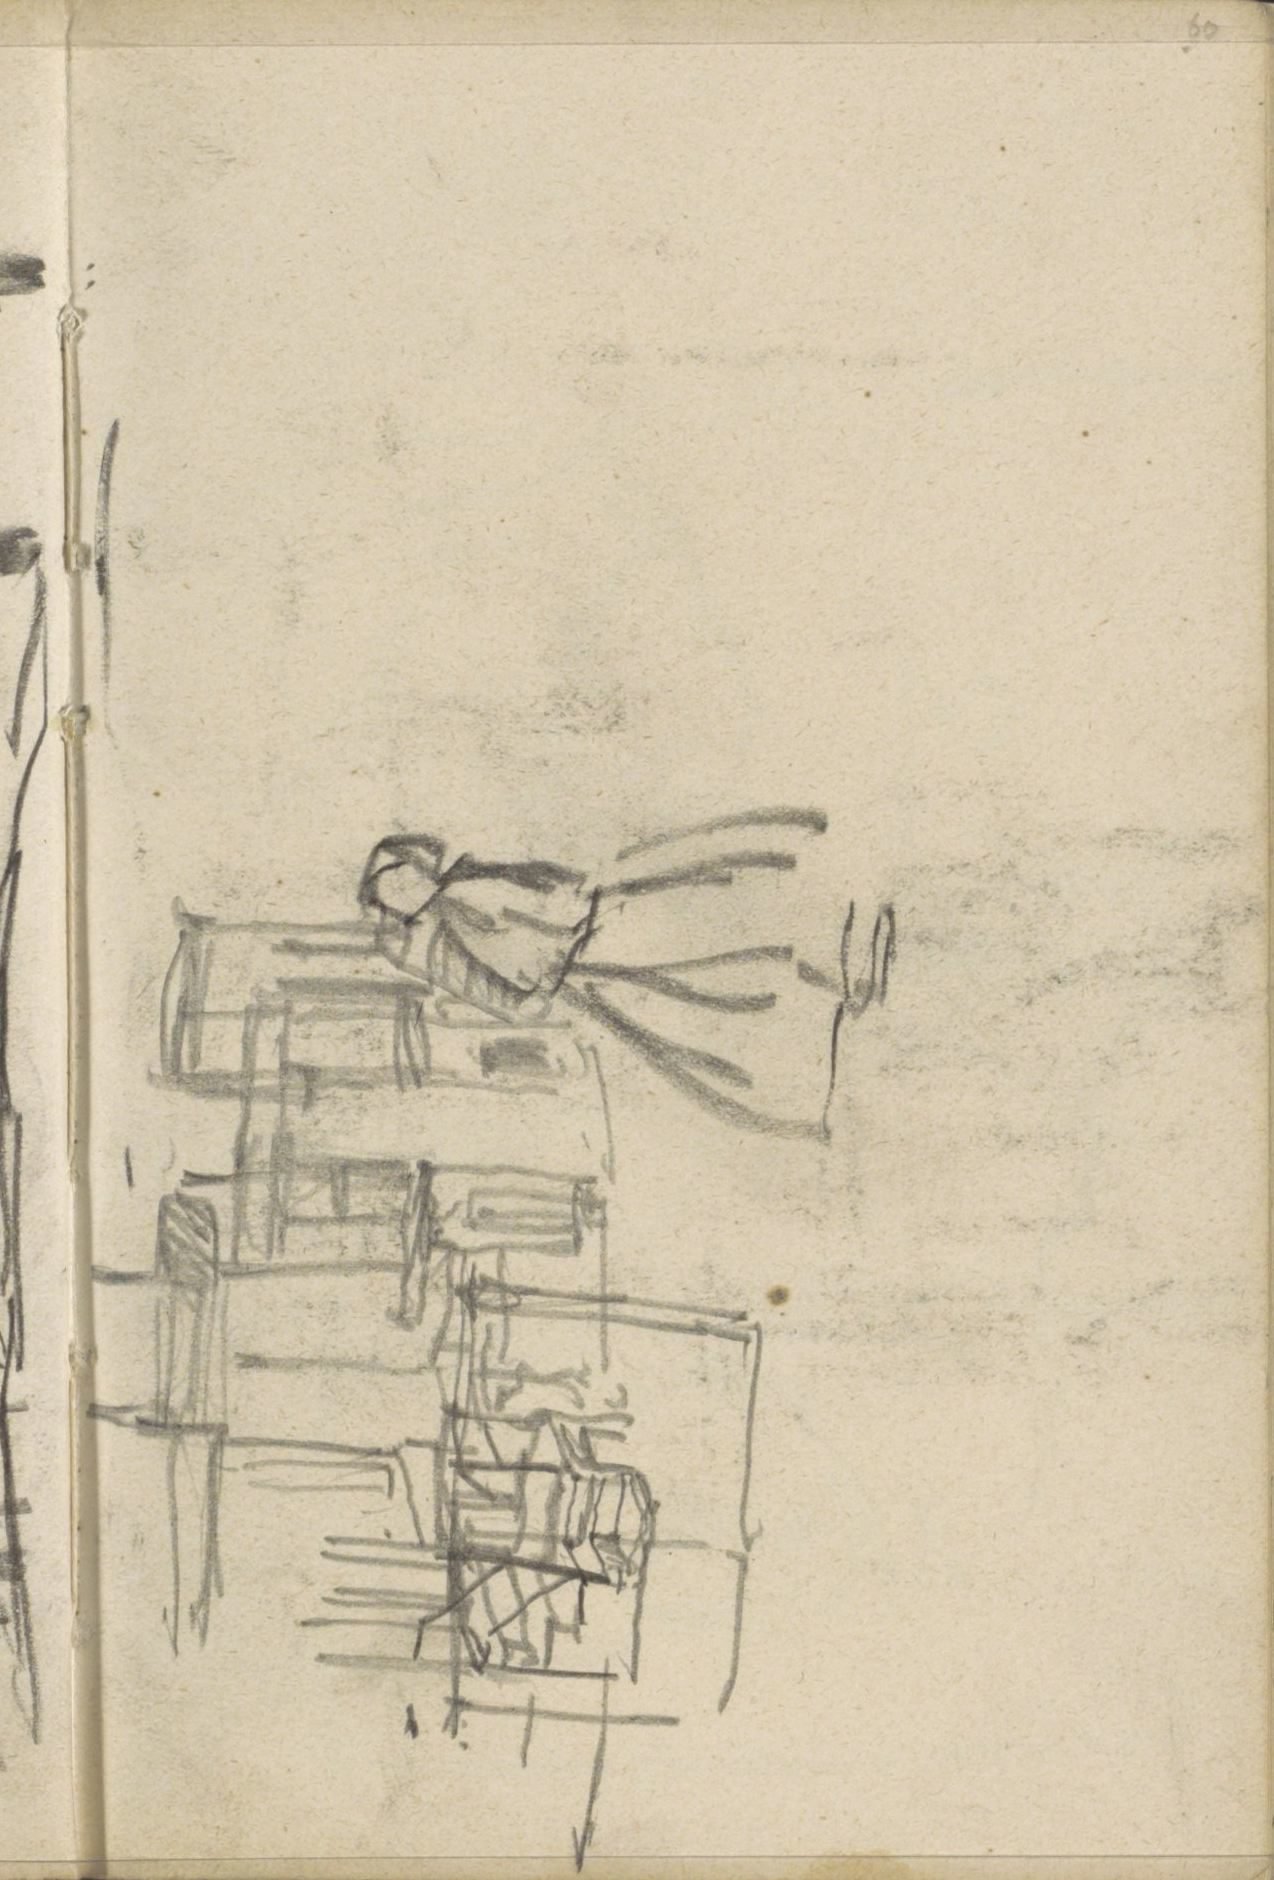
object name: sketchbook leaf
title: Vrouw bij een bordes te Amsterdam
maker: george hendrik breitner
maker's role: draughtsman, painter, print maker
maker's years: 1857-1923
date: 1909-1912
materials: chalk, paper, pencil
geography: amsterdam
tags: urban housing, adult woman, amsterdam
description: Vrouw bij een bordes te Amsterdam. Pagina 60 uit een schetsboek met 46 bladen vervaardigd te Amsterdam.